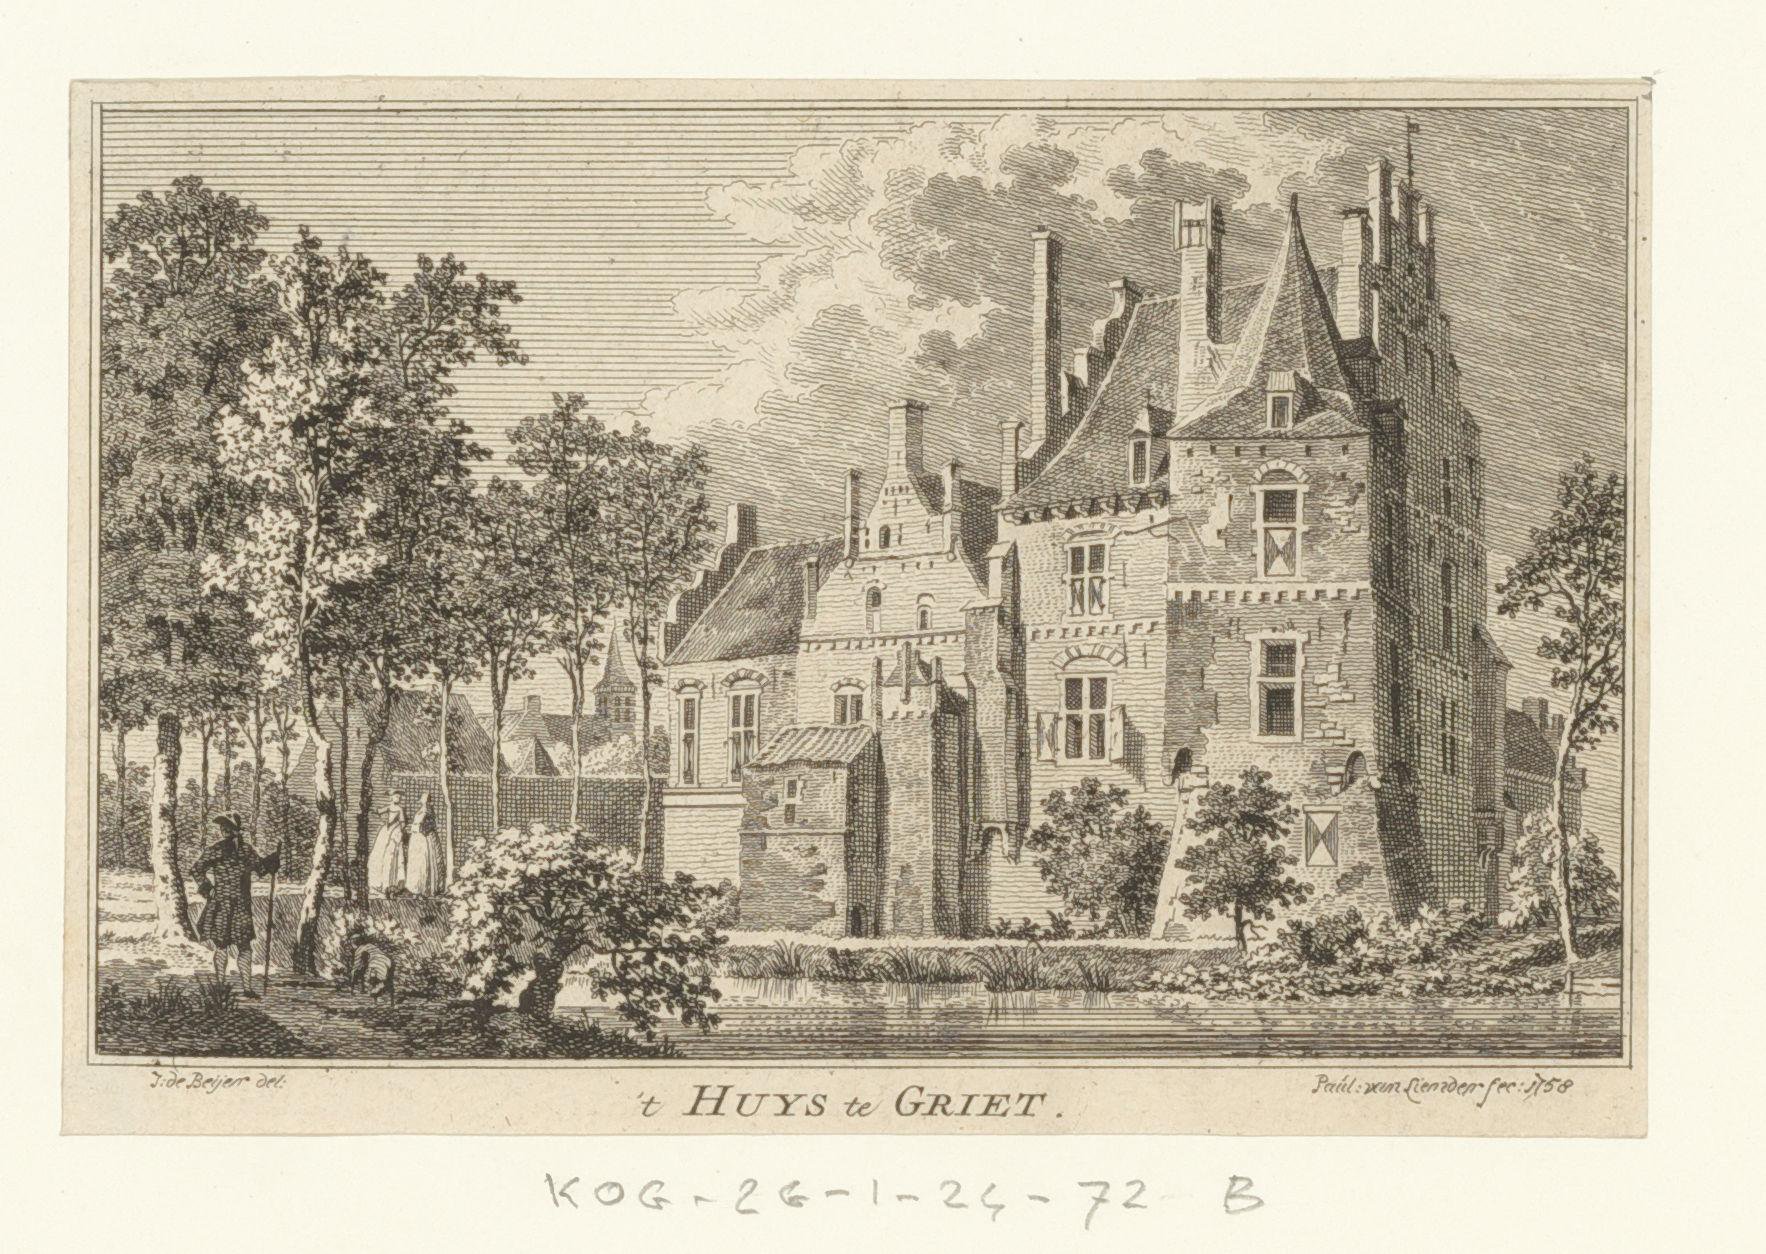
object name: print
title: Huis te Griethausen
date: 1758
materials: paper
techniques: etching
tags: village, church (exterior)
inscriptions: collector's mark: Lugt 1641, stamp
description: Een huis in het Duitse dorp Griethausen. De prent maakt deel uit van een 100-delige serie met gezichten op dorpen en steden te Kleef. Onderwerpsrubrieken binnen de Atlas Zeden en Gewoonten: Zeden en Gewoonten in Engeren Zin, De Woning. Kastelen en buitenplaatsen. Het Kleefse.